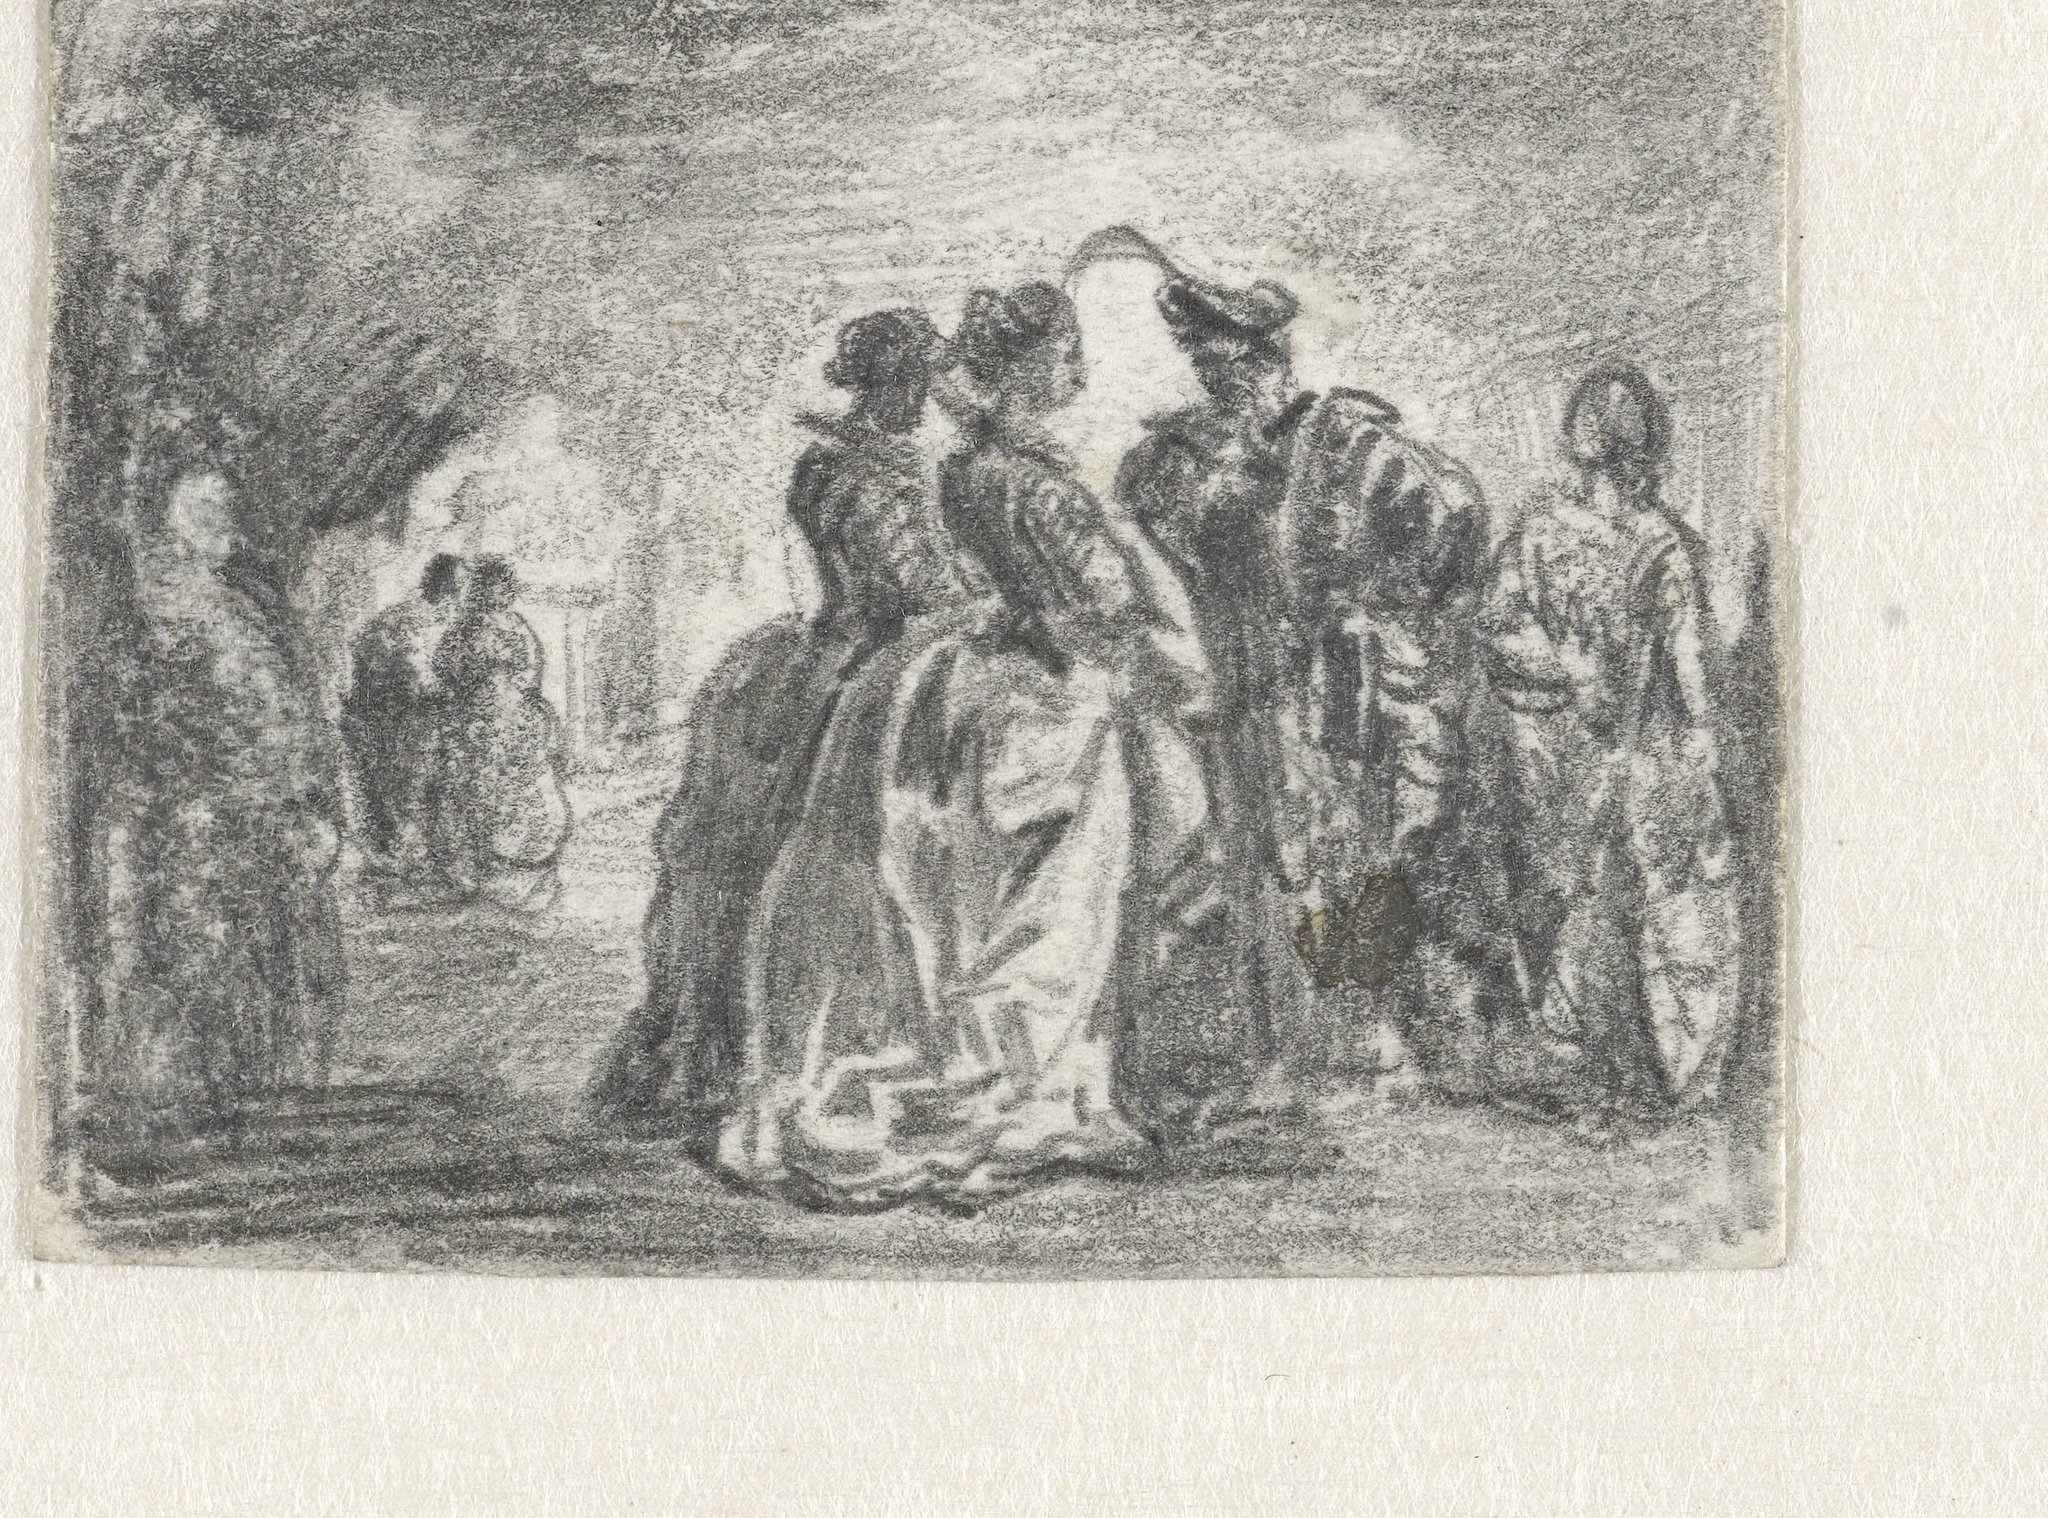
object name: drawing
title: Studie van een groep mensen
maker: johannes jacobus bertelman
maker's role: draughtsman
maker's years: 1821-1899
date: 1831-1899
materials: paper, pencil